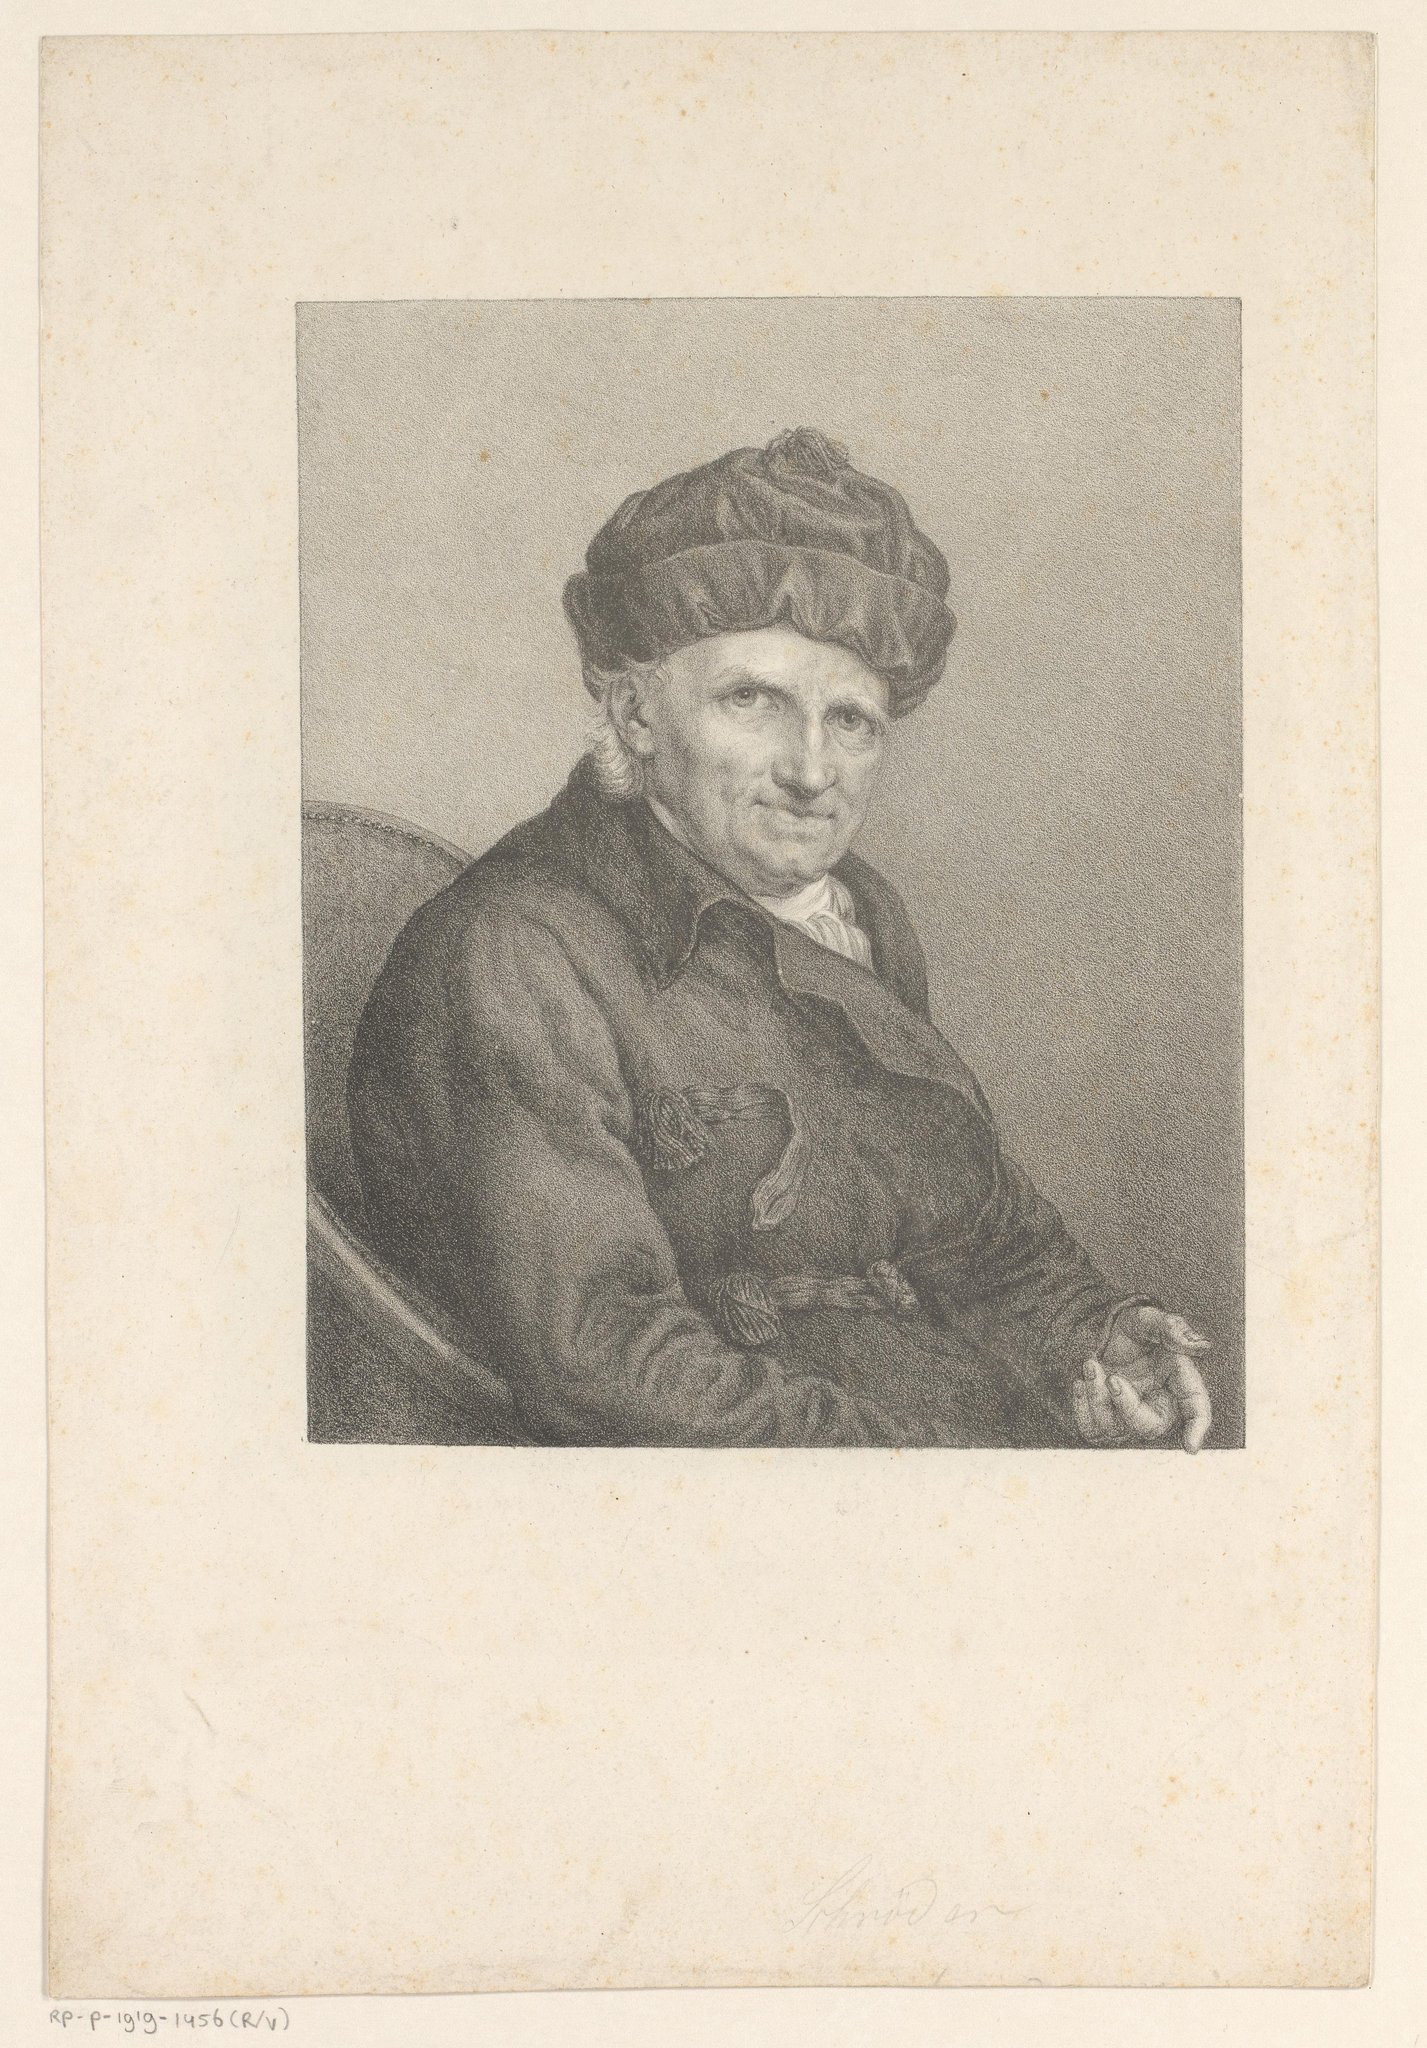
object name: print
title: Portret van Johann Joachim Spalding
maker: maas (graveur)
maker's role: print maker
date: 1809-1899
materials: paper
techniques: lithograph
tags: berlin, johann joachim spalding, head-gear, historical persons (+ (full) bust portrait)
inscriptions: collector's mark: Lugt 2228